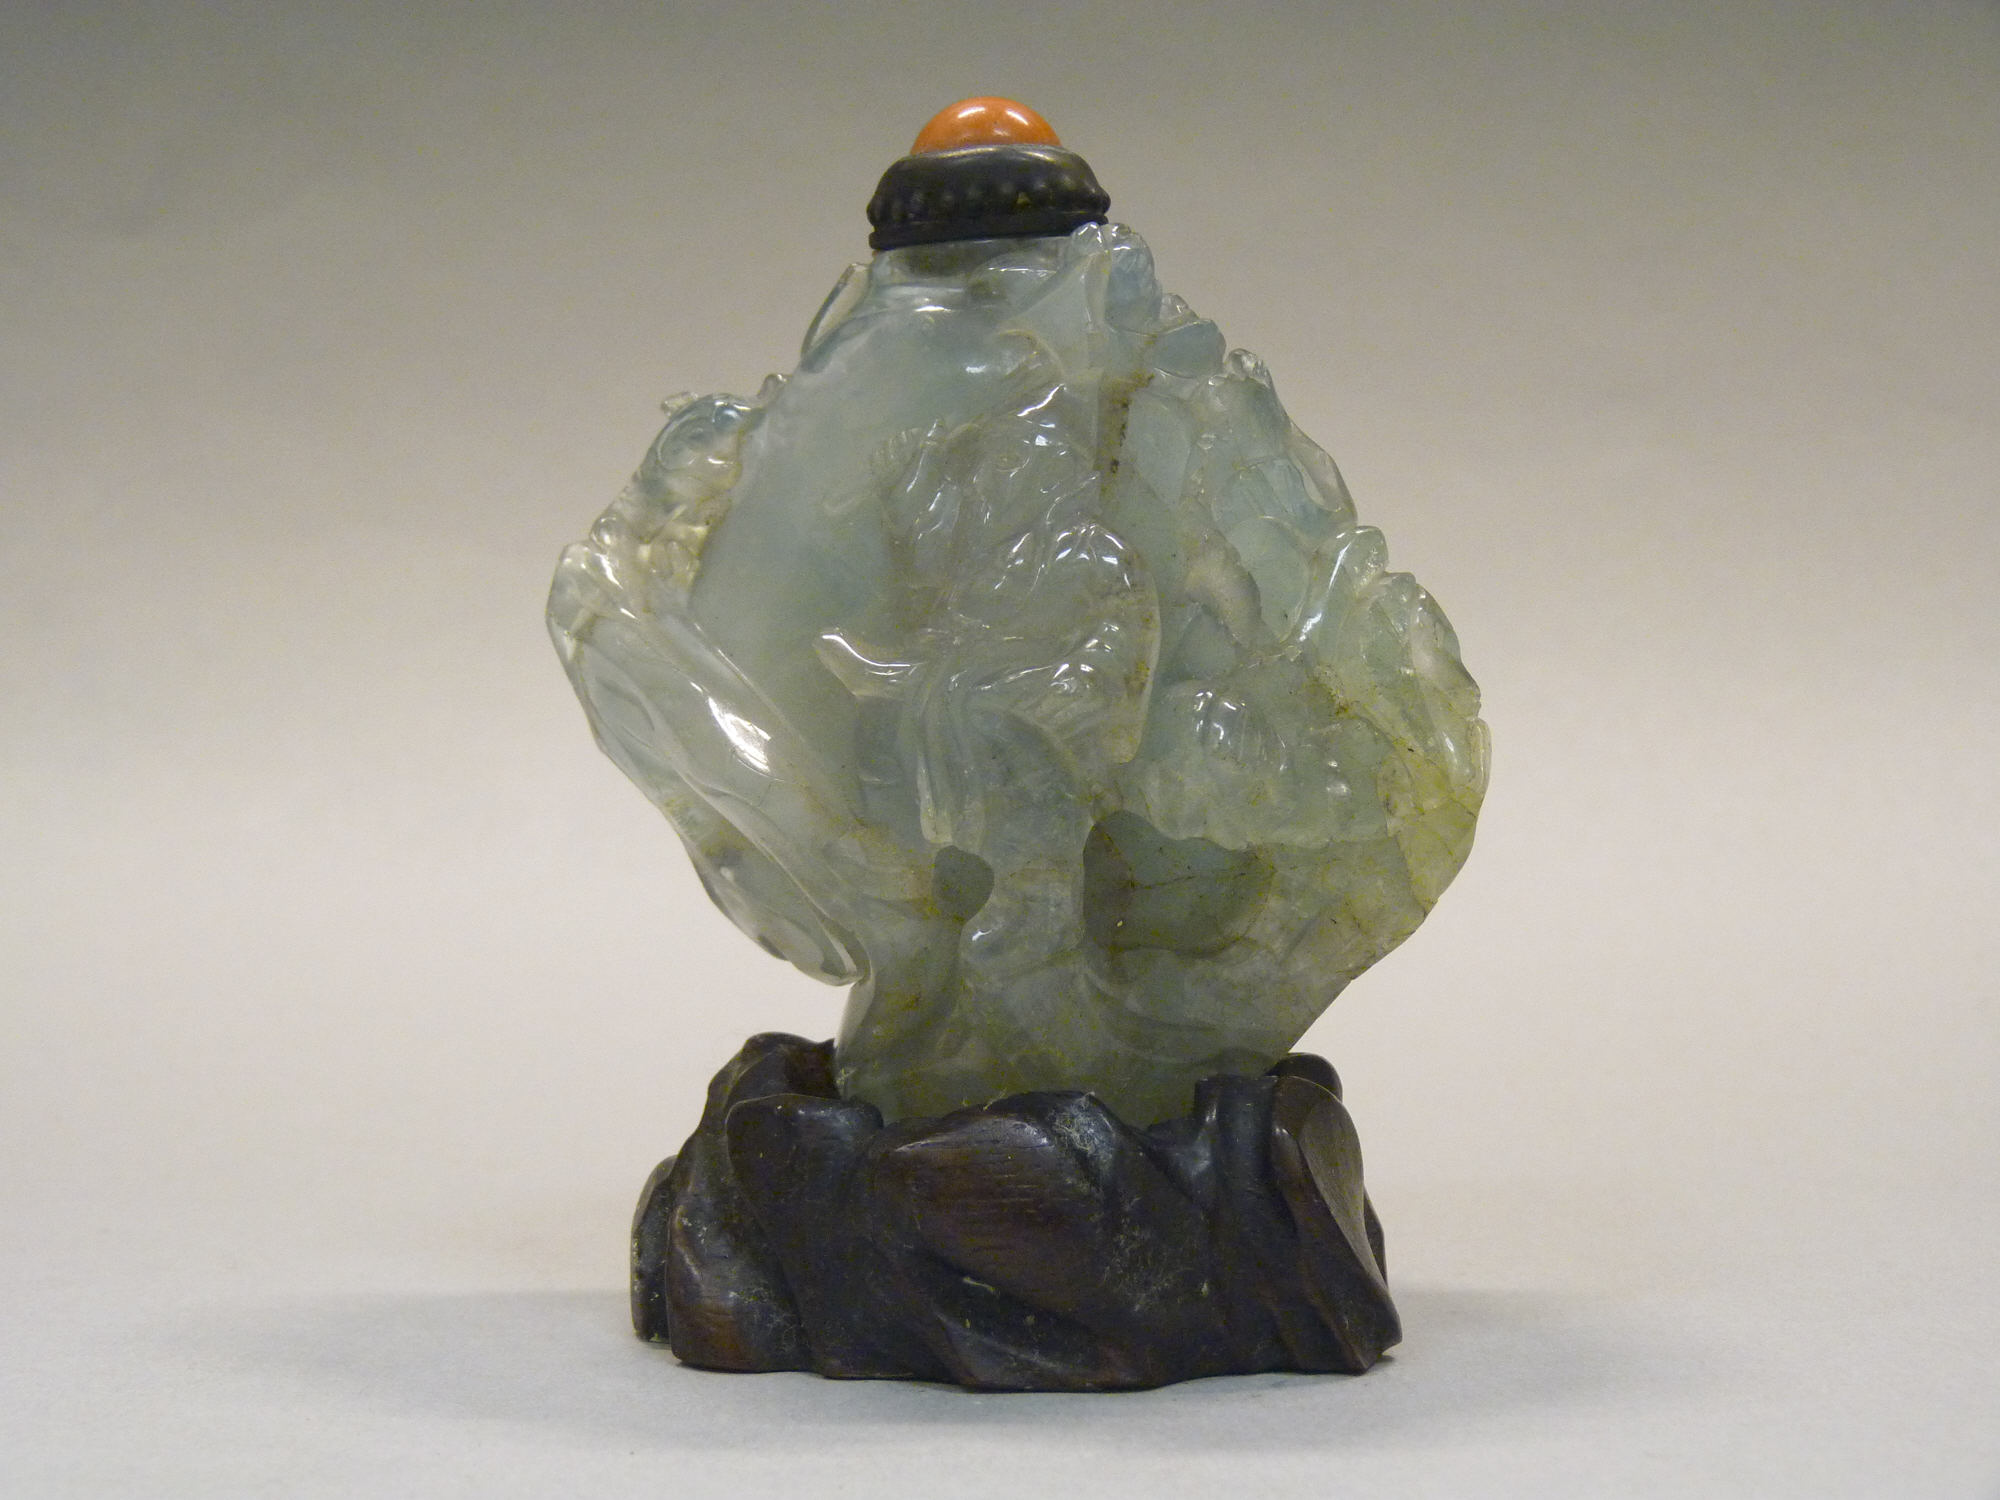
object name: snuff bottle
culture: chinese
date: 1736-1795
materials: stone, coral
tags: human figures